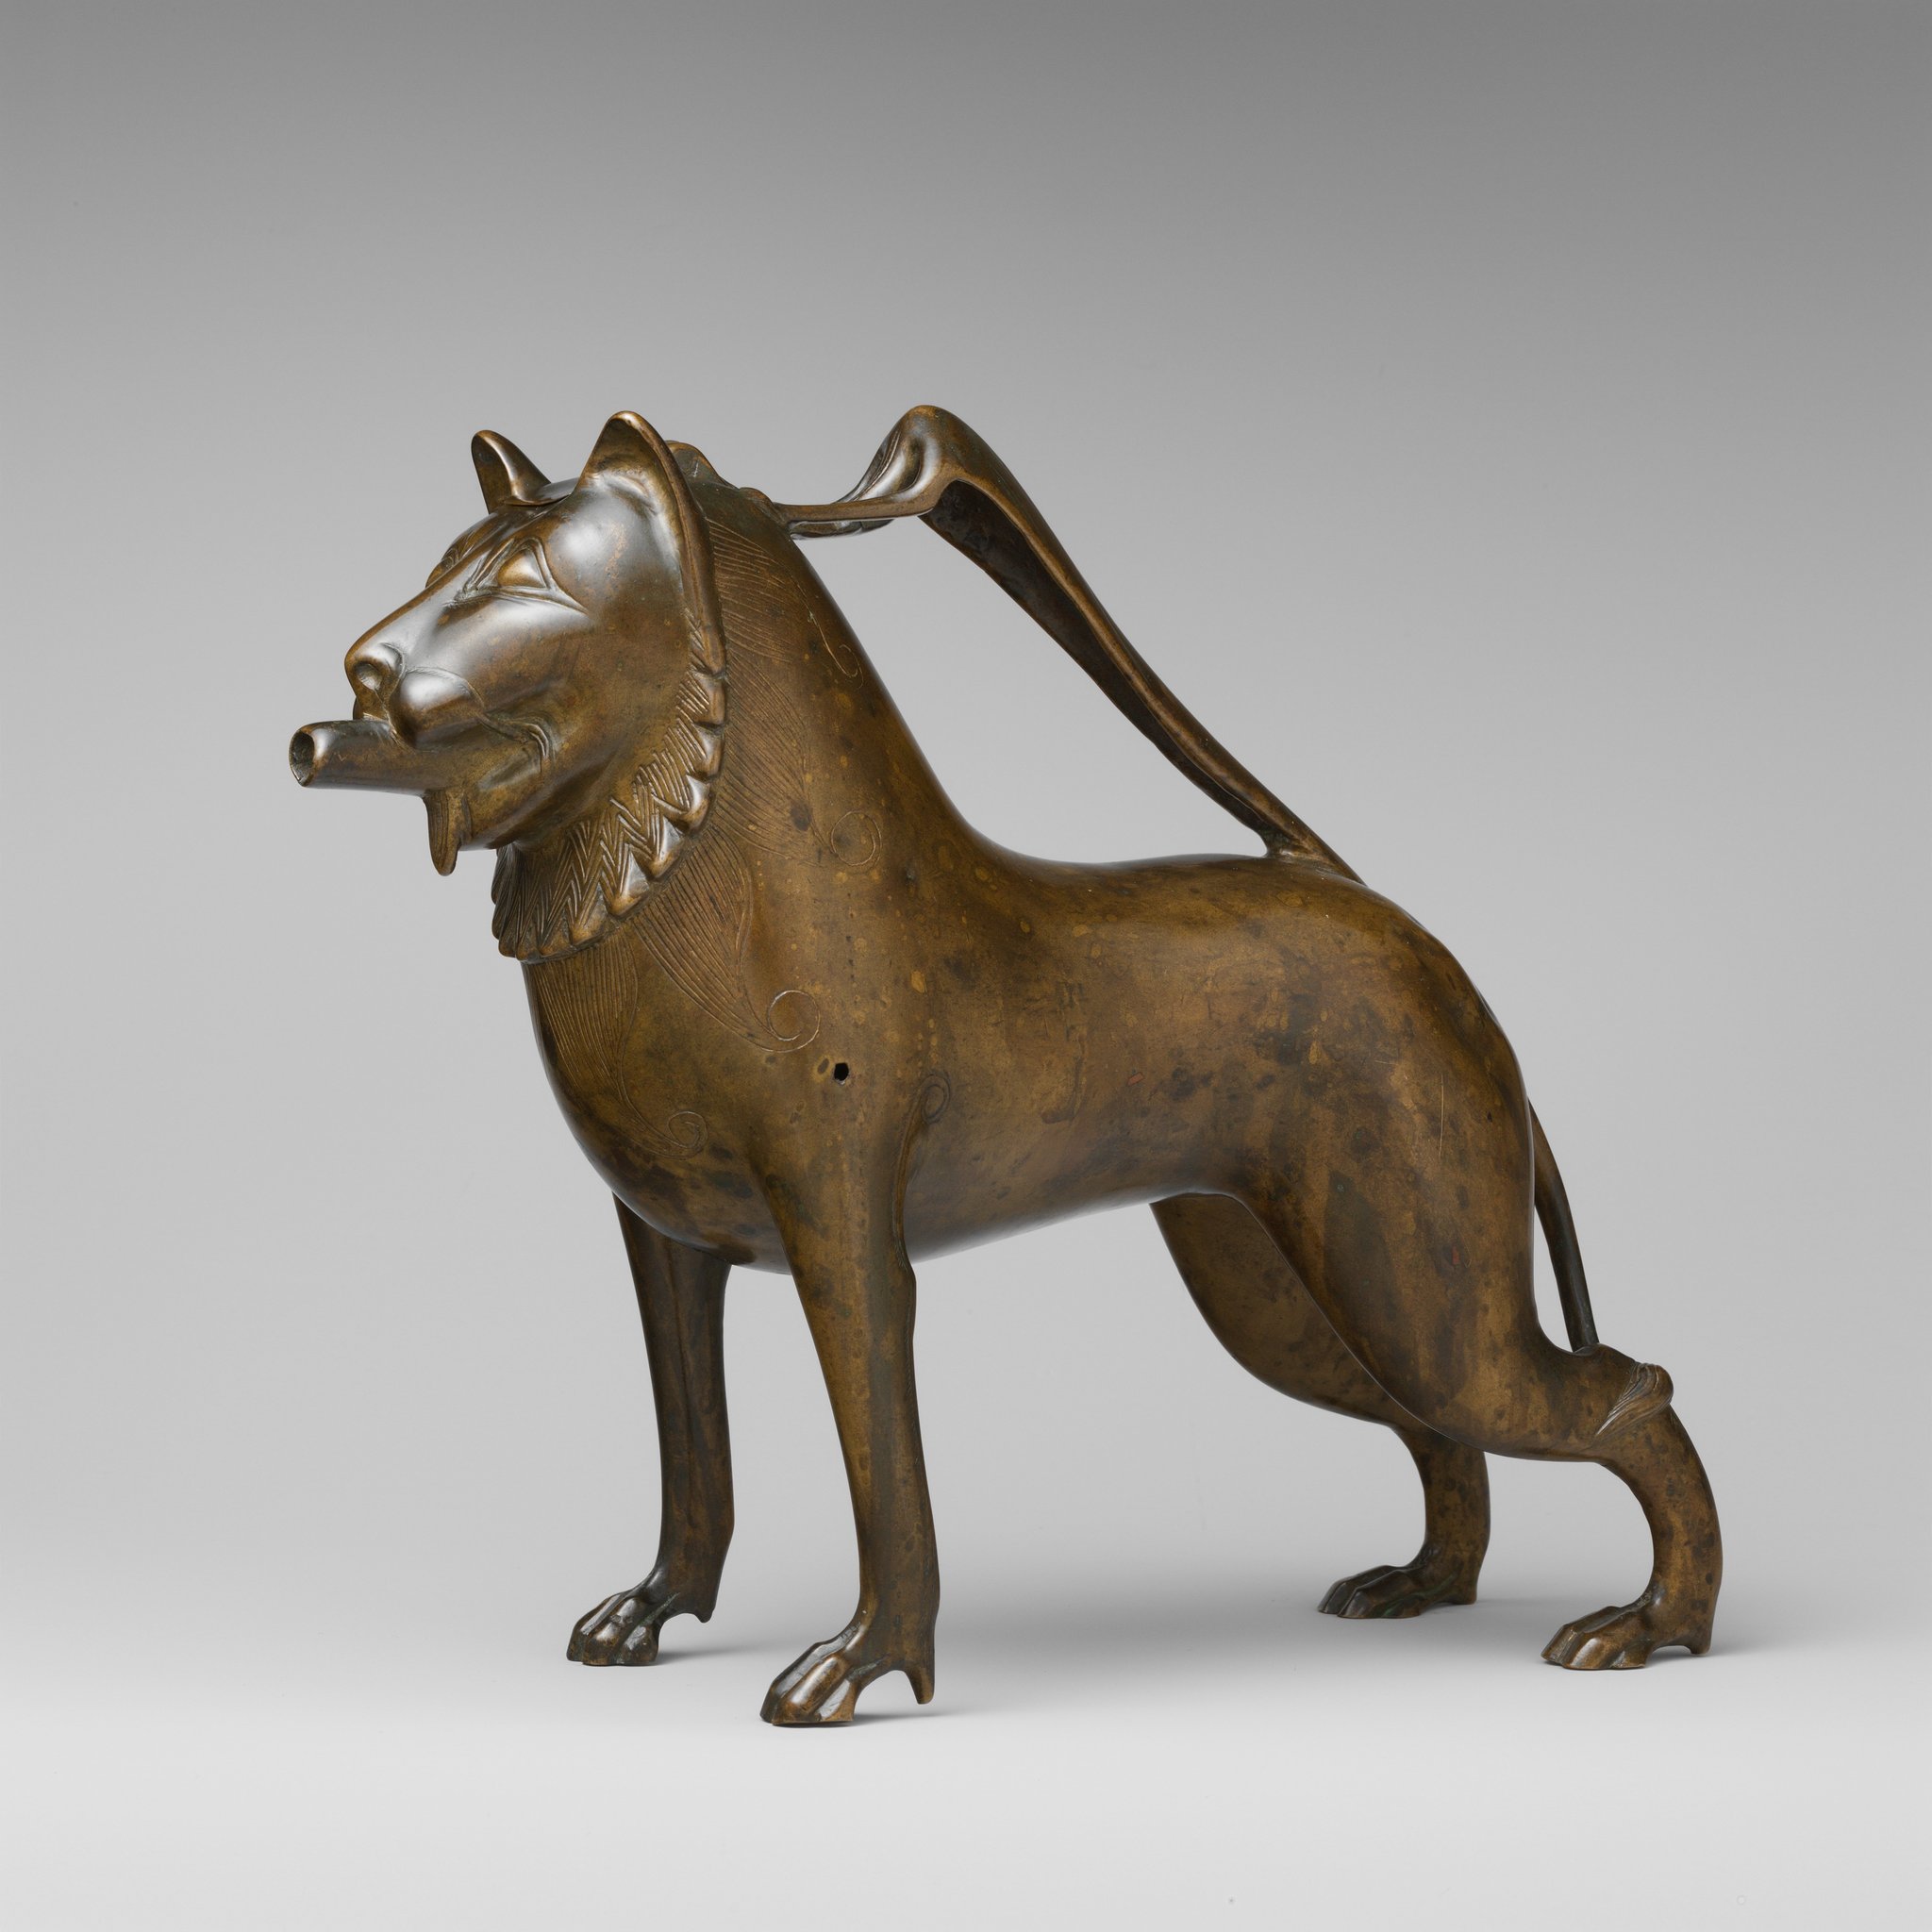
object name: aquamanile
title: Aquamanile in the Form of a Lion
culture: german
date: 1267-1333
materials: copper alloy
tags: lions